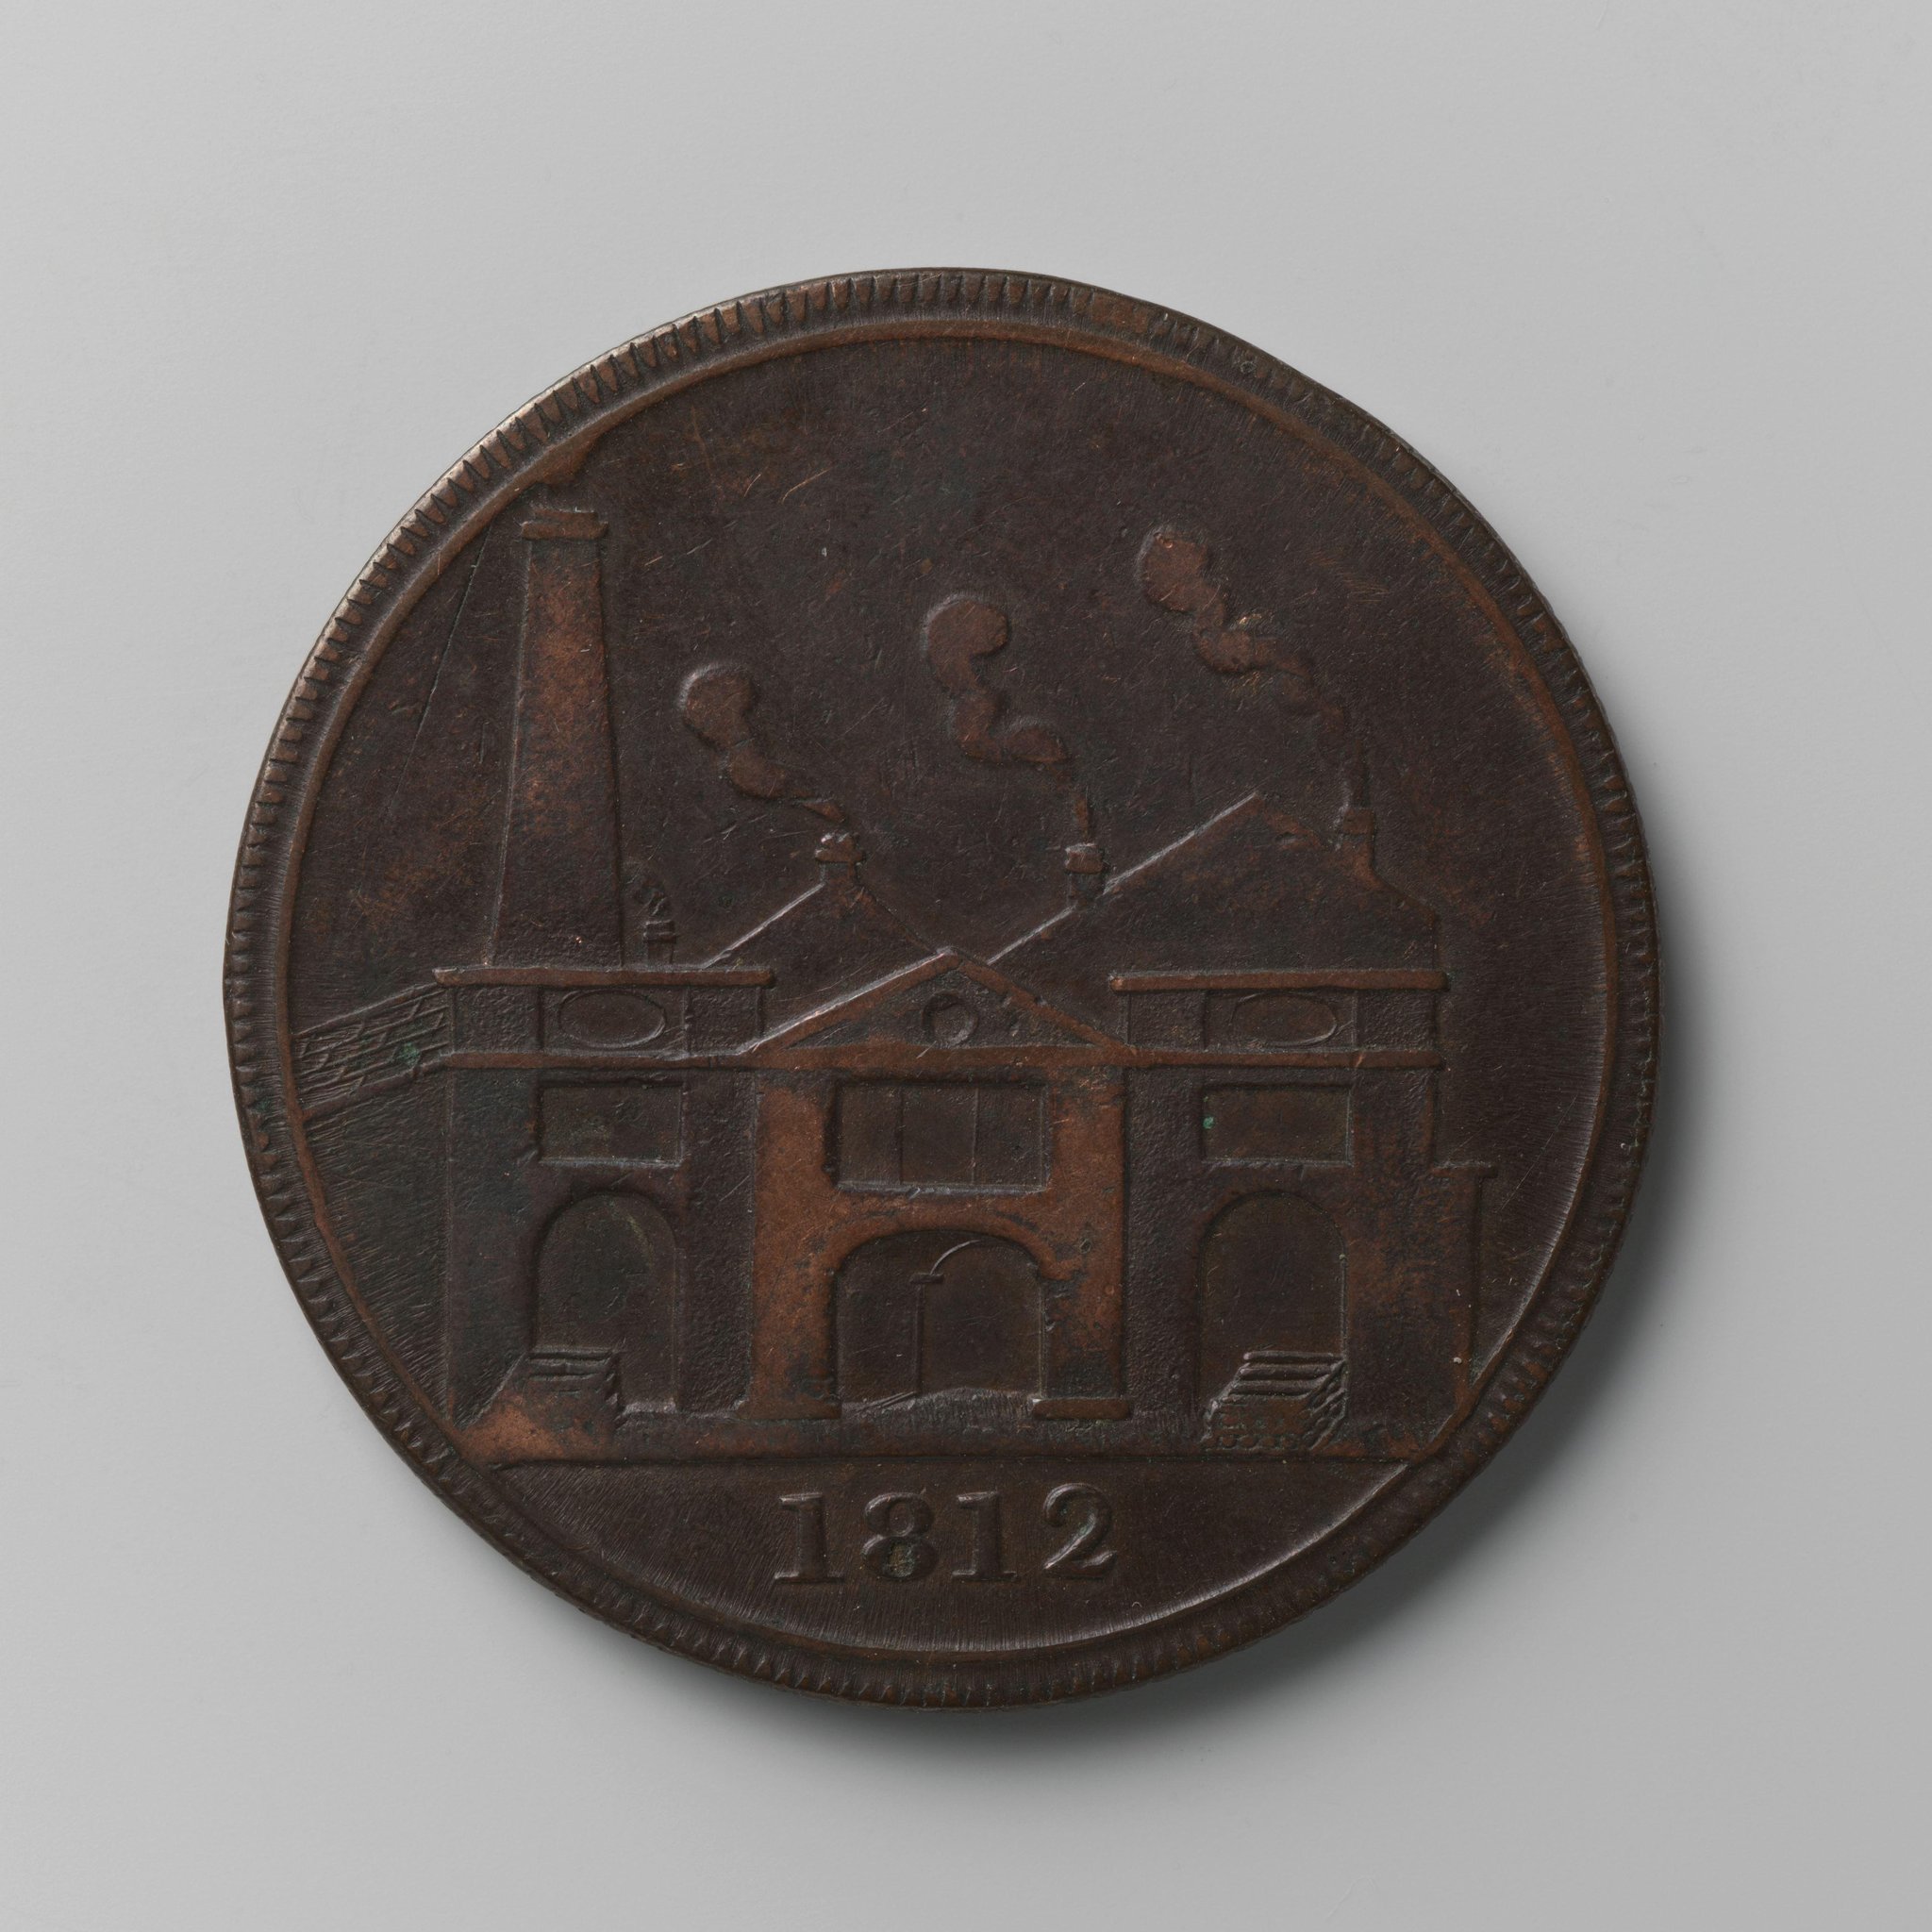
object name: penny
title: Penny-token, Hull, Engeland, 1812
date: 1812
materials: copper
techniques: striking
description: Koperen particuliere munt. Voorzijde: fabrieksgebouw, waaonder jaartal. Keerzijde: waarde-aanduiding, waaronder drie-regelig opschrift. Kabelrand.